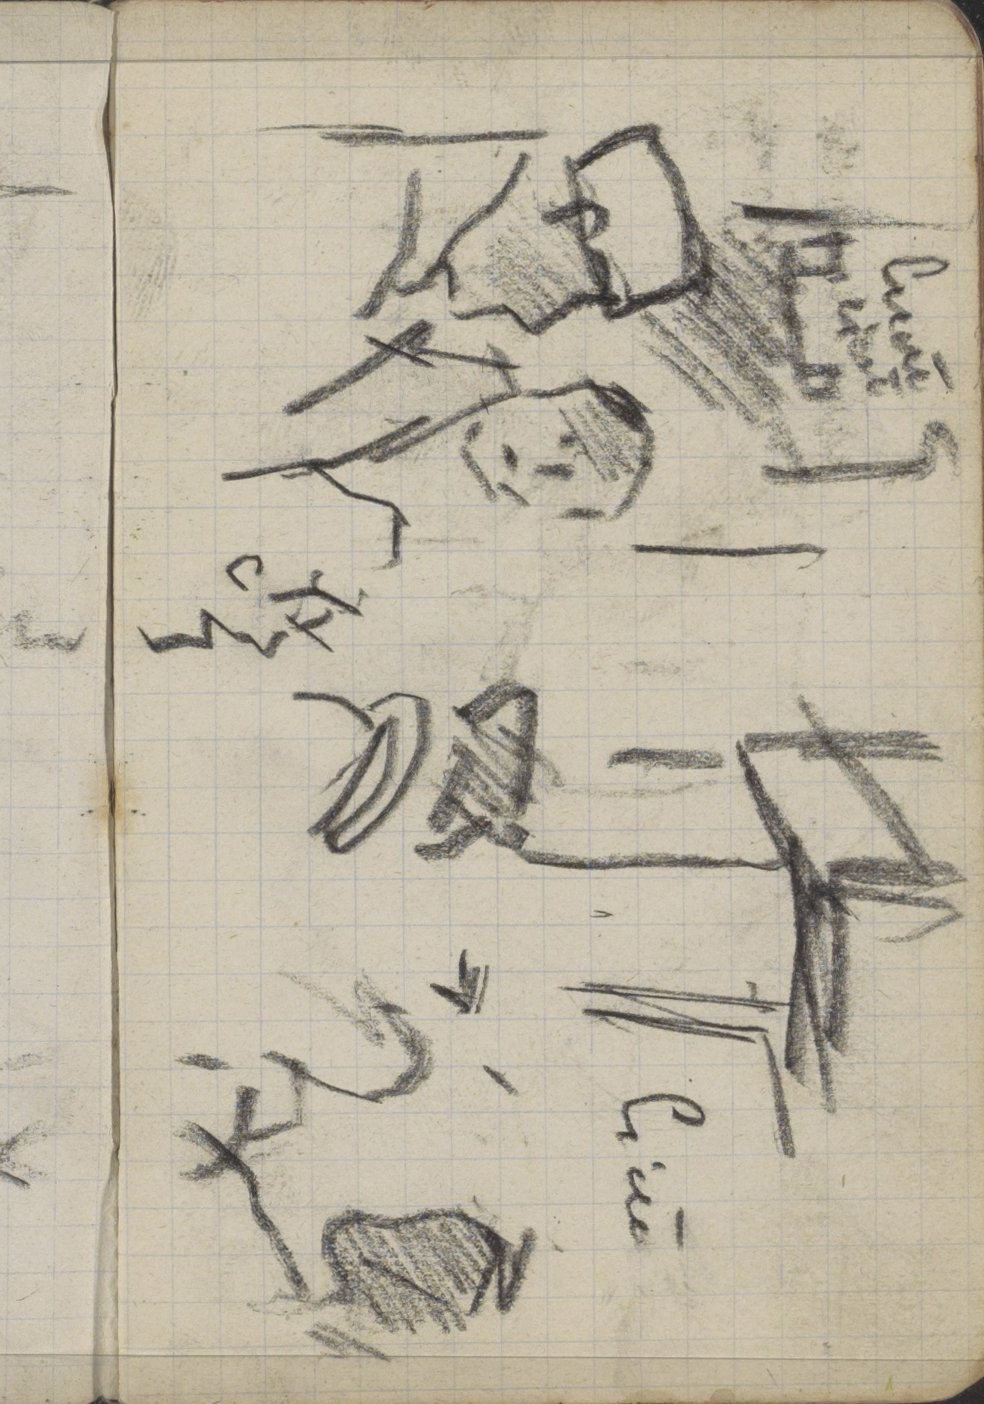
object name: sketchbook leaf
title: Figuren en gebouwen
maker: george hendrik breitner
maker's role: draughtsman, painter, print maker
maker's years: 1857-1923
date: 1893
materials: chalk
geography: amsterdam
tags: urban housing, adult woman, adult man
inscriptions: annotation: ‘[...]’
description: Figuren. Op de achtergrond gebouwen. Pagina 6 uit een schetsboek met 30 bladen vervaardigd in Amsterdam.